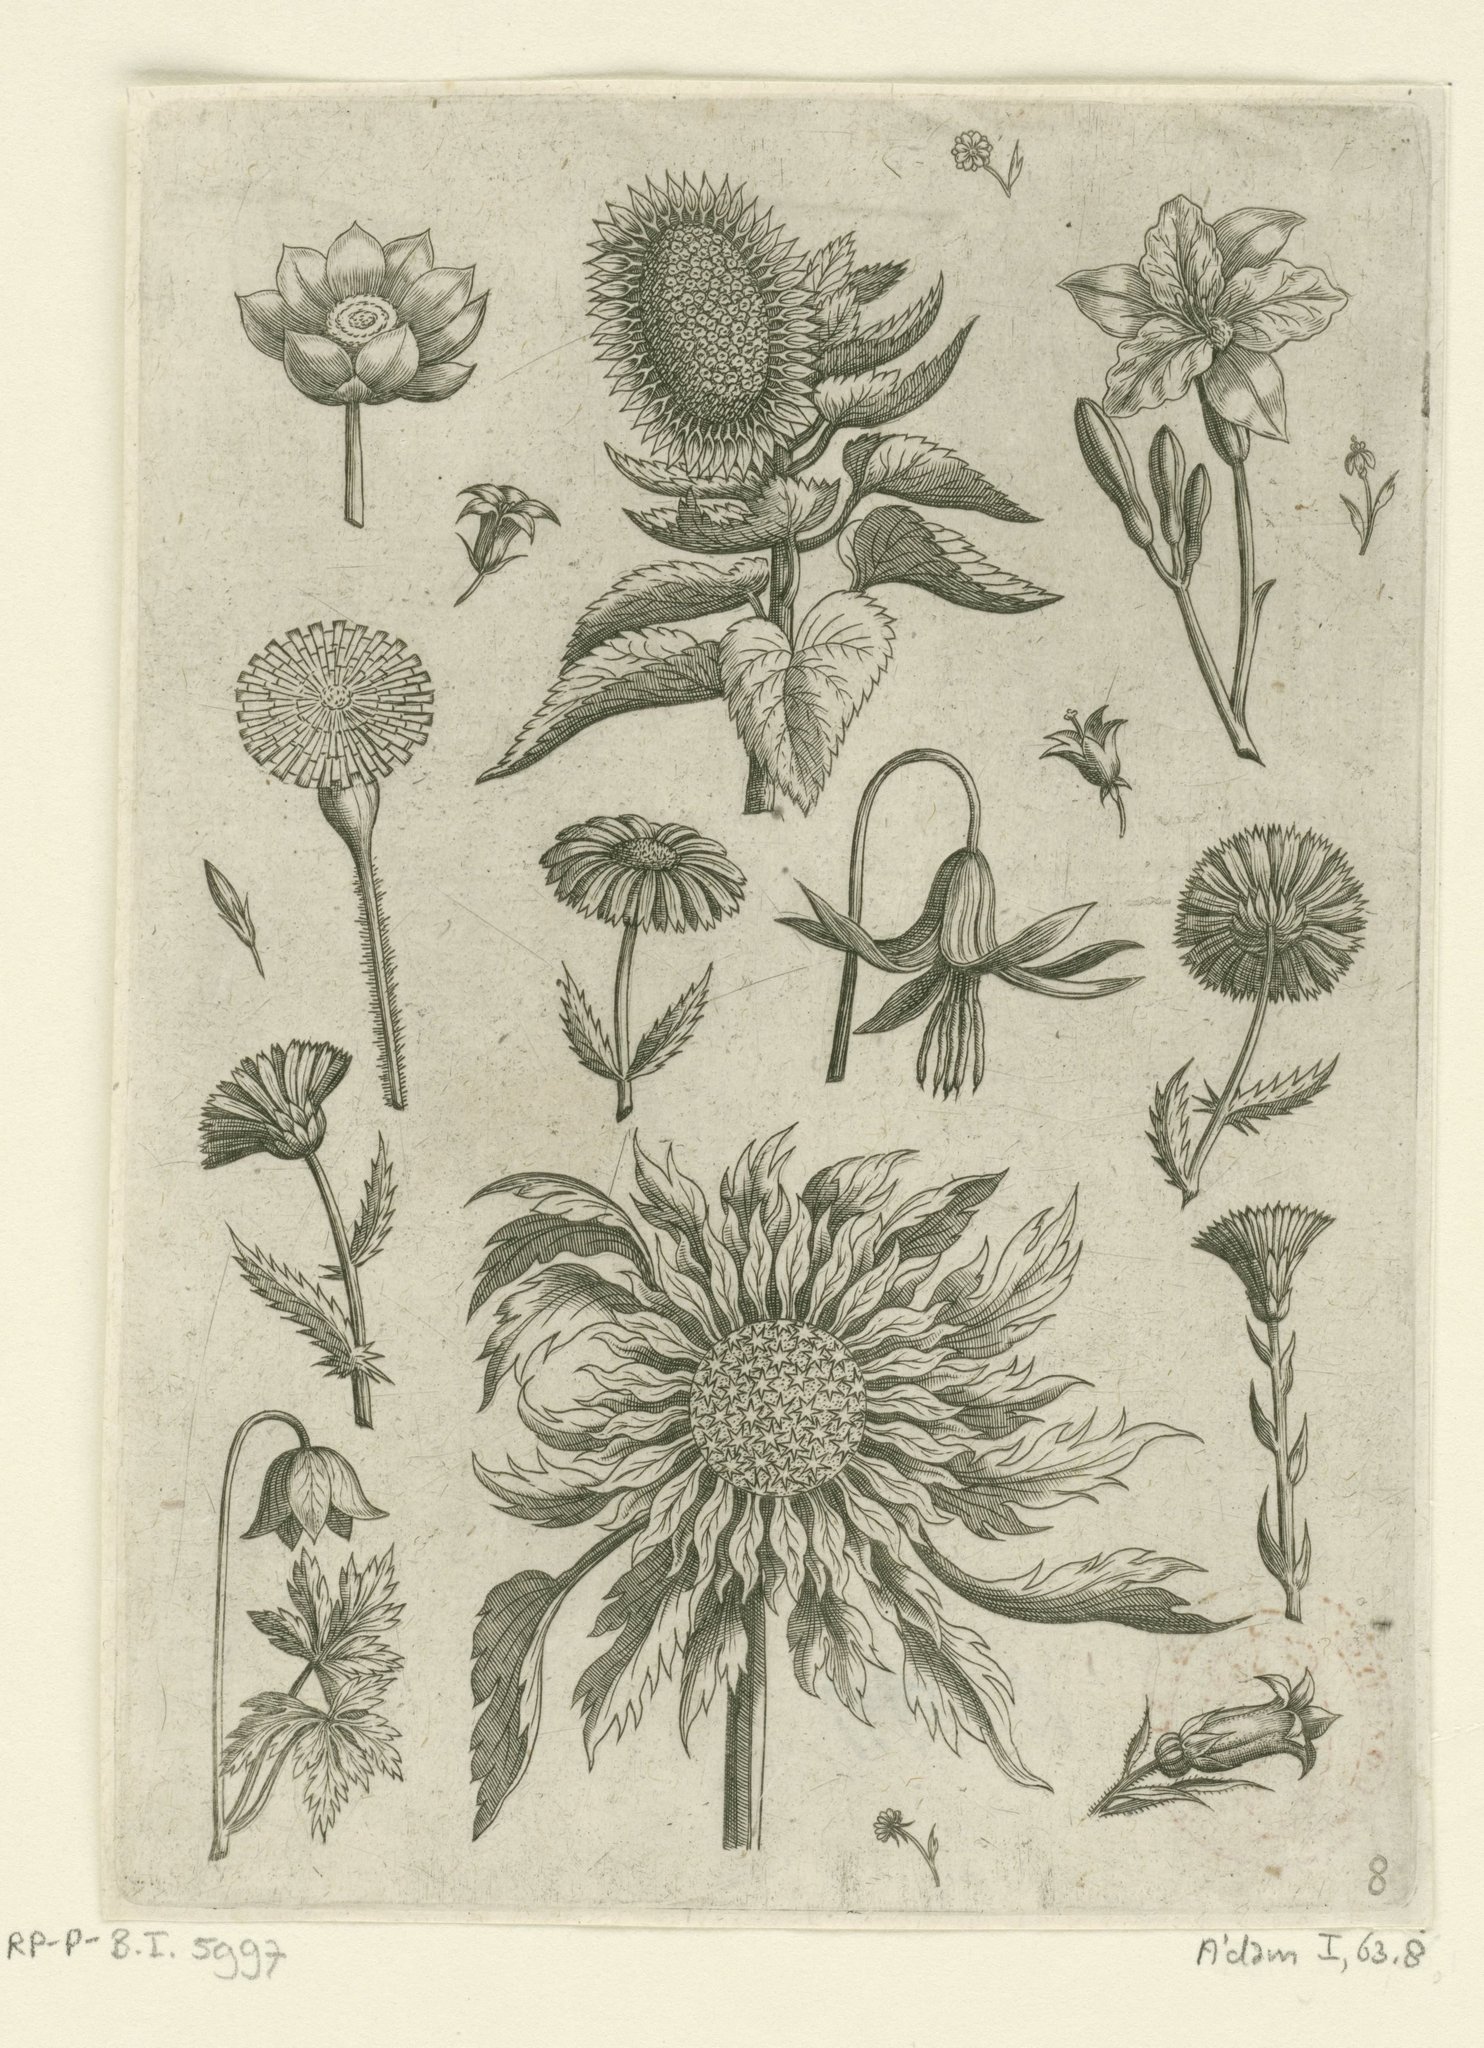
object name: ornament print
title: Zonnebloem en andere bloemen.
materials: paper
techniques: engraving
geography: netherlands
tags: flowers, flowers: sunflower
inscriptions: collector's mark: Lugt 240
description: Links in het midden een muizenoor. Blad 8 van 21 genummerde bladen met titelblad afkomstig uit een serie van 24.